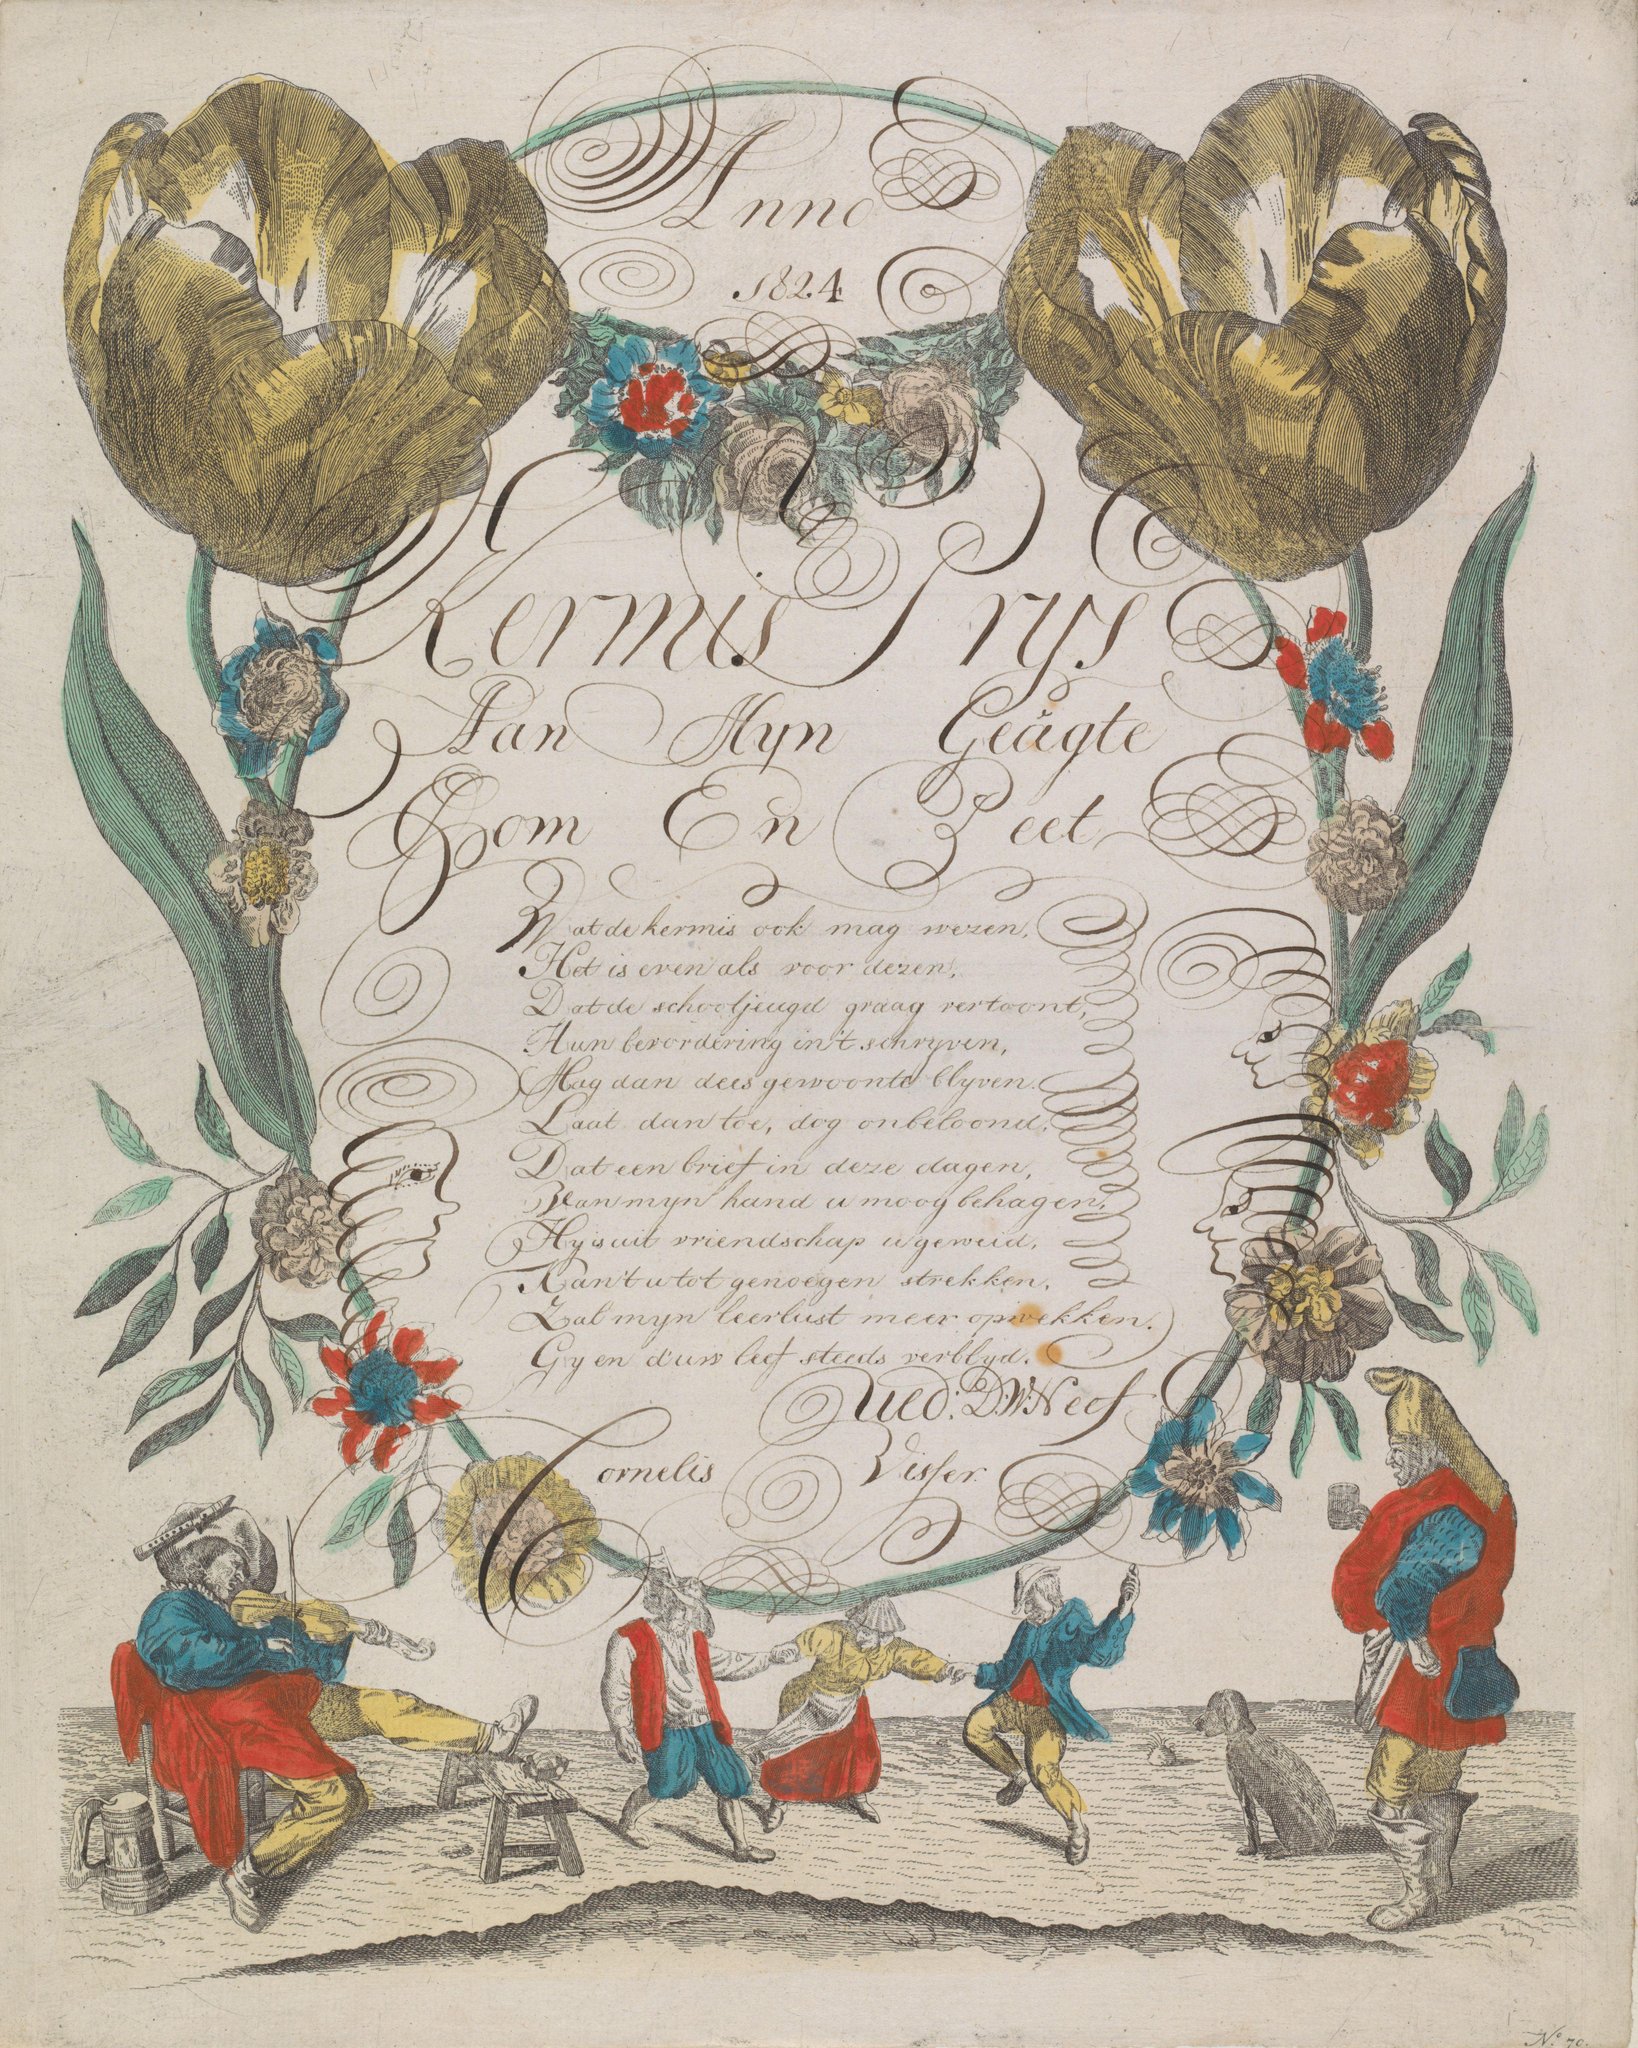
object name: popular print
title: Wensbrief met bloemen en dansende mensen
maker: Anonymous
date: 1824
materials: ink, paper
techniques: calligraphy, colour, etching, pen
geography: netherlands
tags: flowers, group dancing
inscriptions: collector's mark: Lugt 2760, inscription: ‘Kermis prijs / Aan myn geàgte / Oom en peet / Wat de kermis ook mag wezen ...’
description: Wensbrief met beschreven cartouche binnen een decoratief kader met voorstellingen van bloemen en dansende mensen. Handgeschreven bericht in kalligrafie (kermisprijs) door Cornelis Visser aan zijn oom en peet. Genummerd rechtsonder: No. 70.